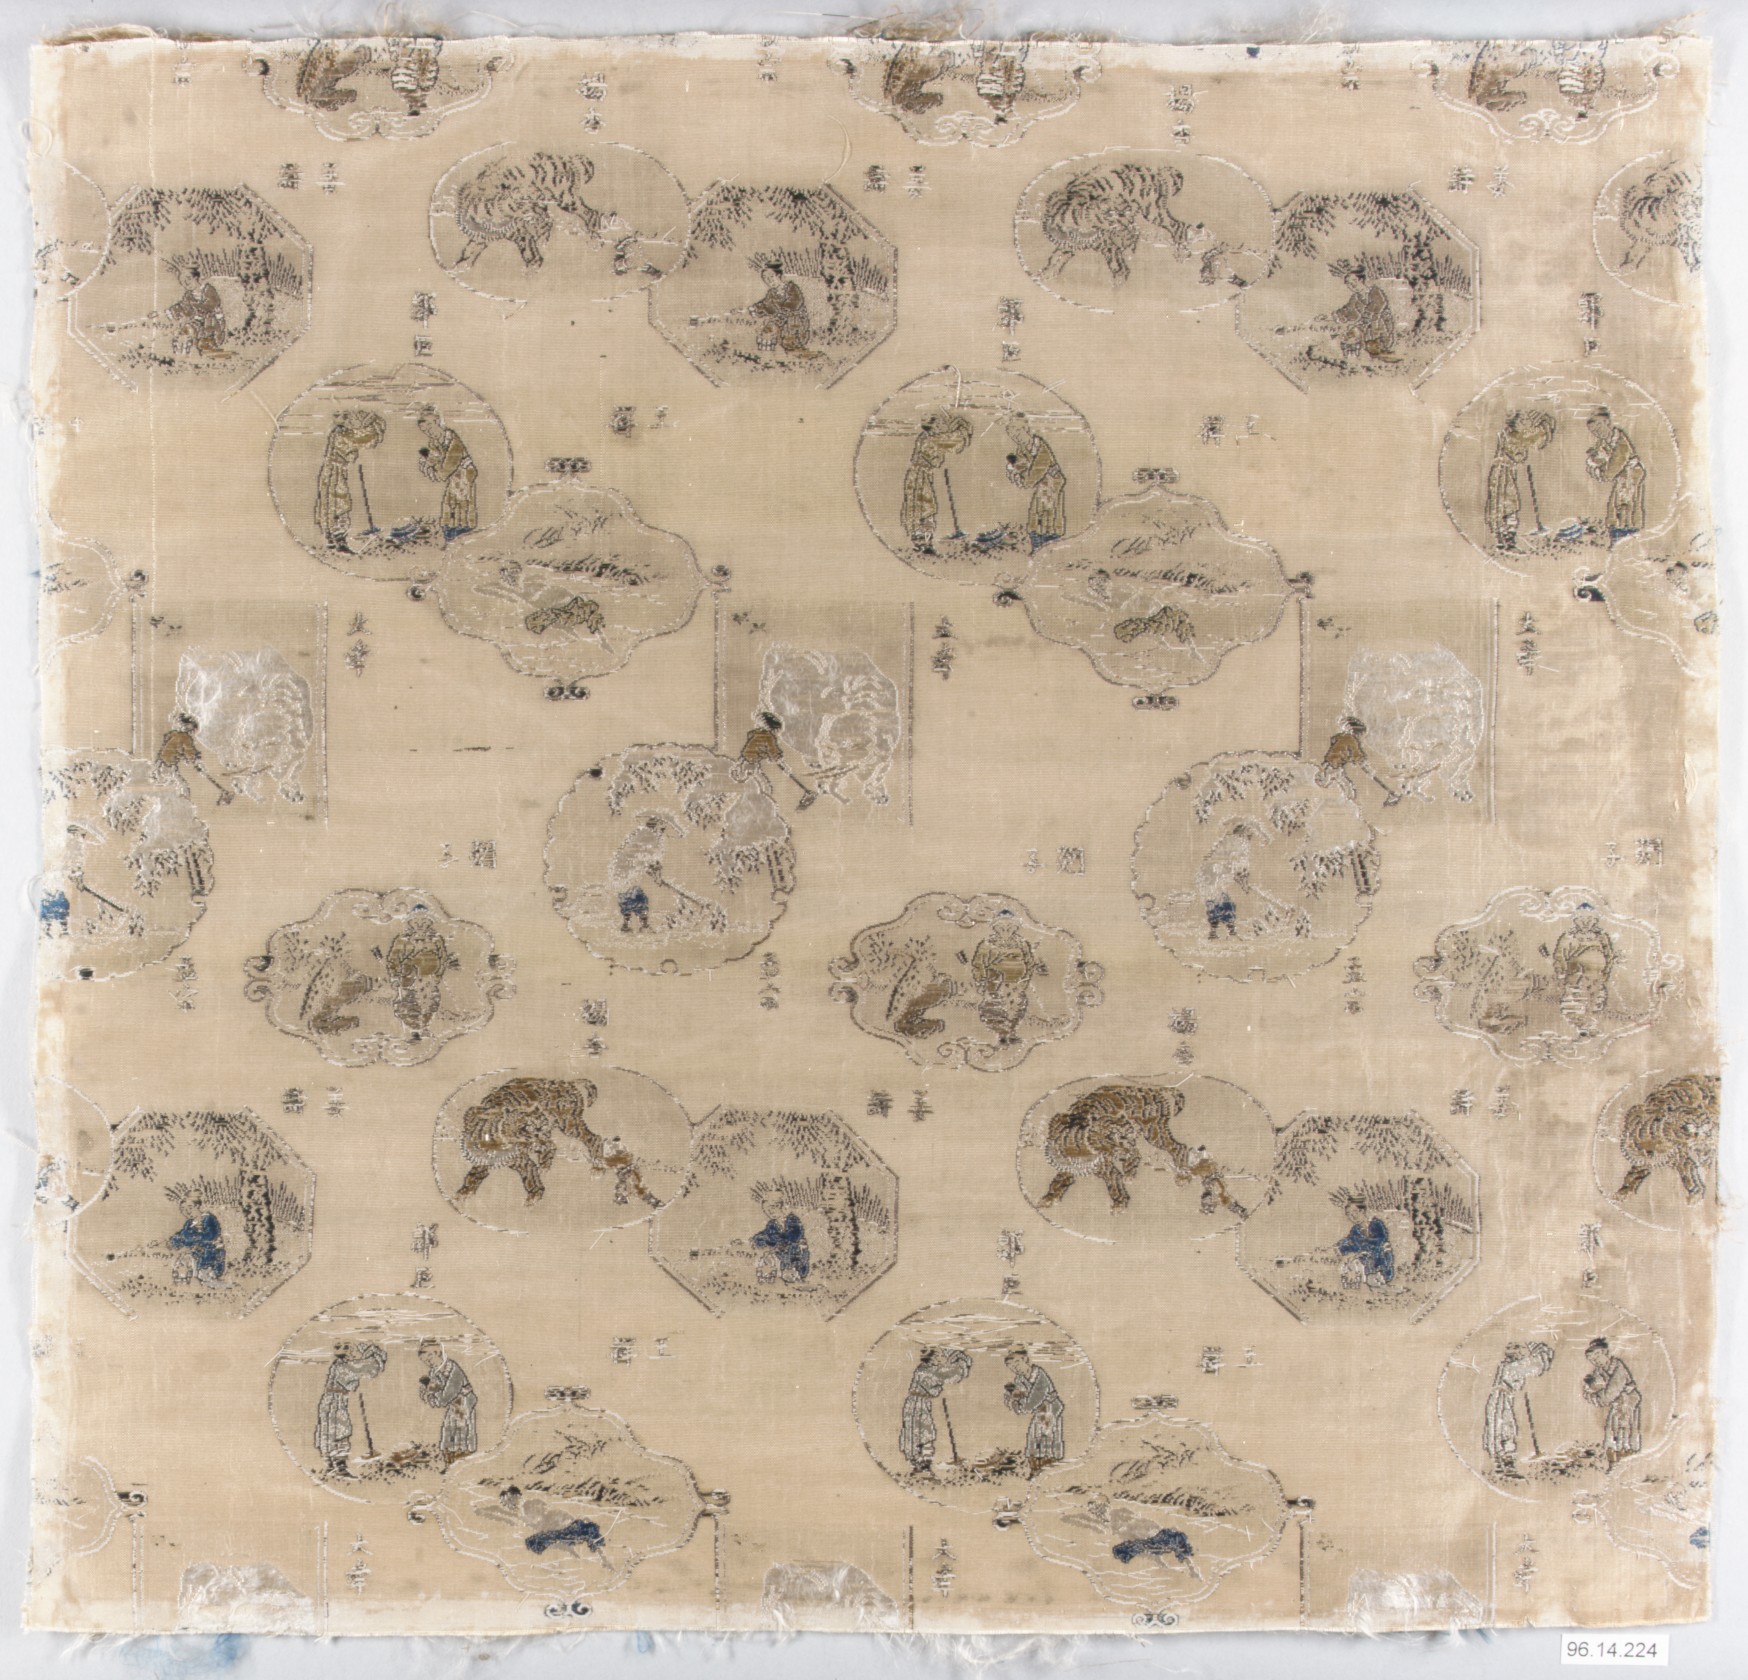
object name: piece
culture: japanese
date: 1701-1900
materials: silk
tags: human figures